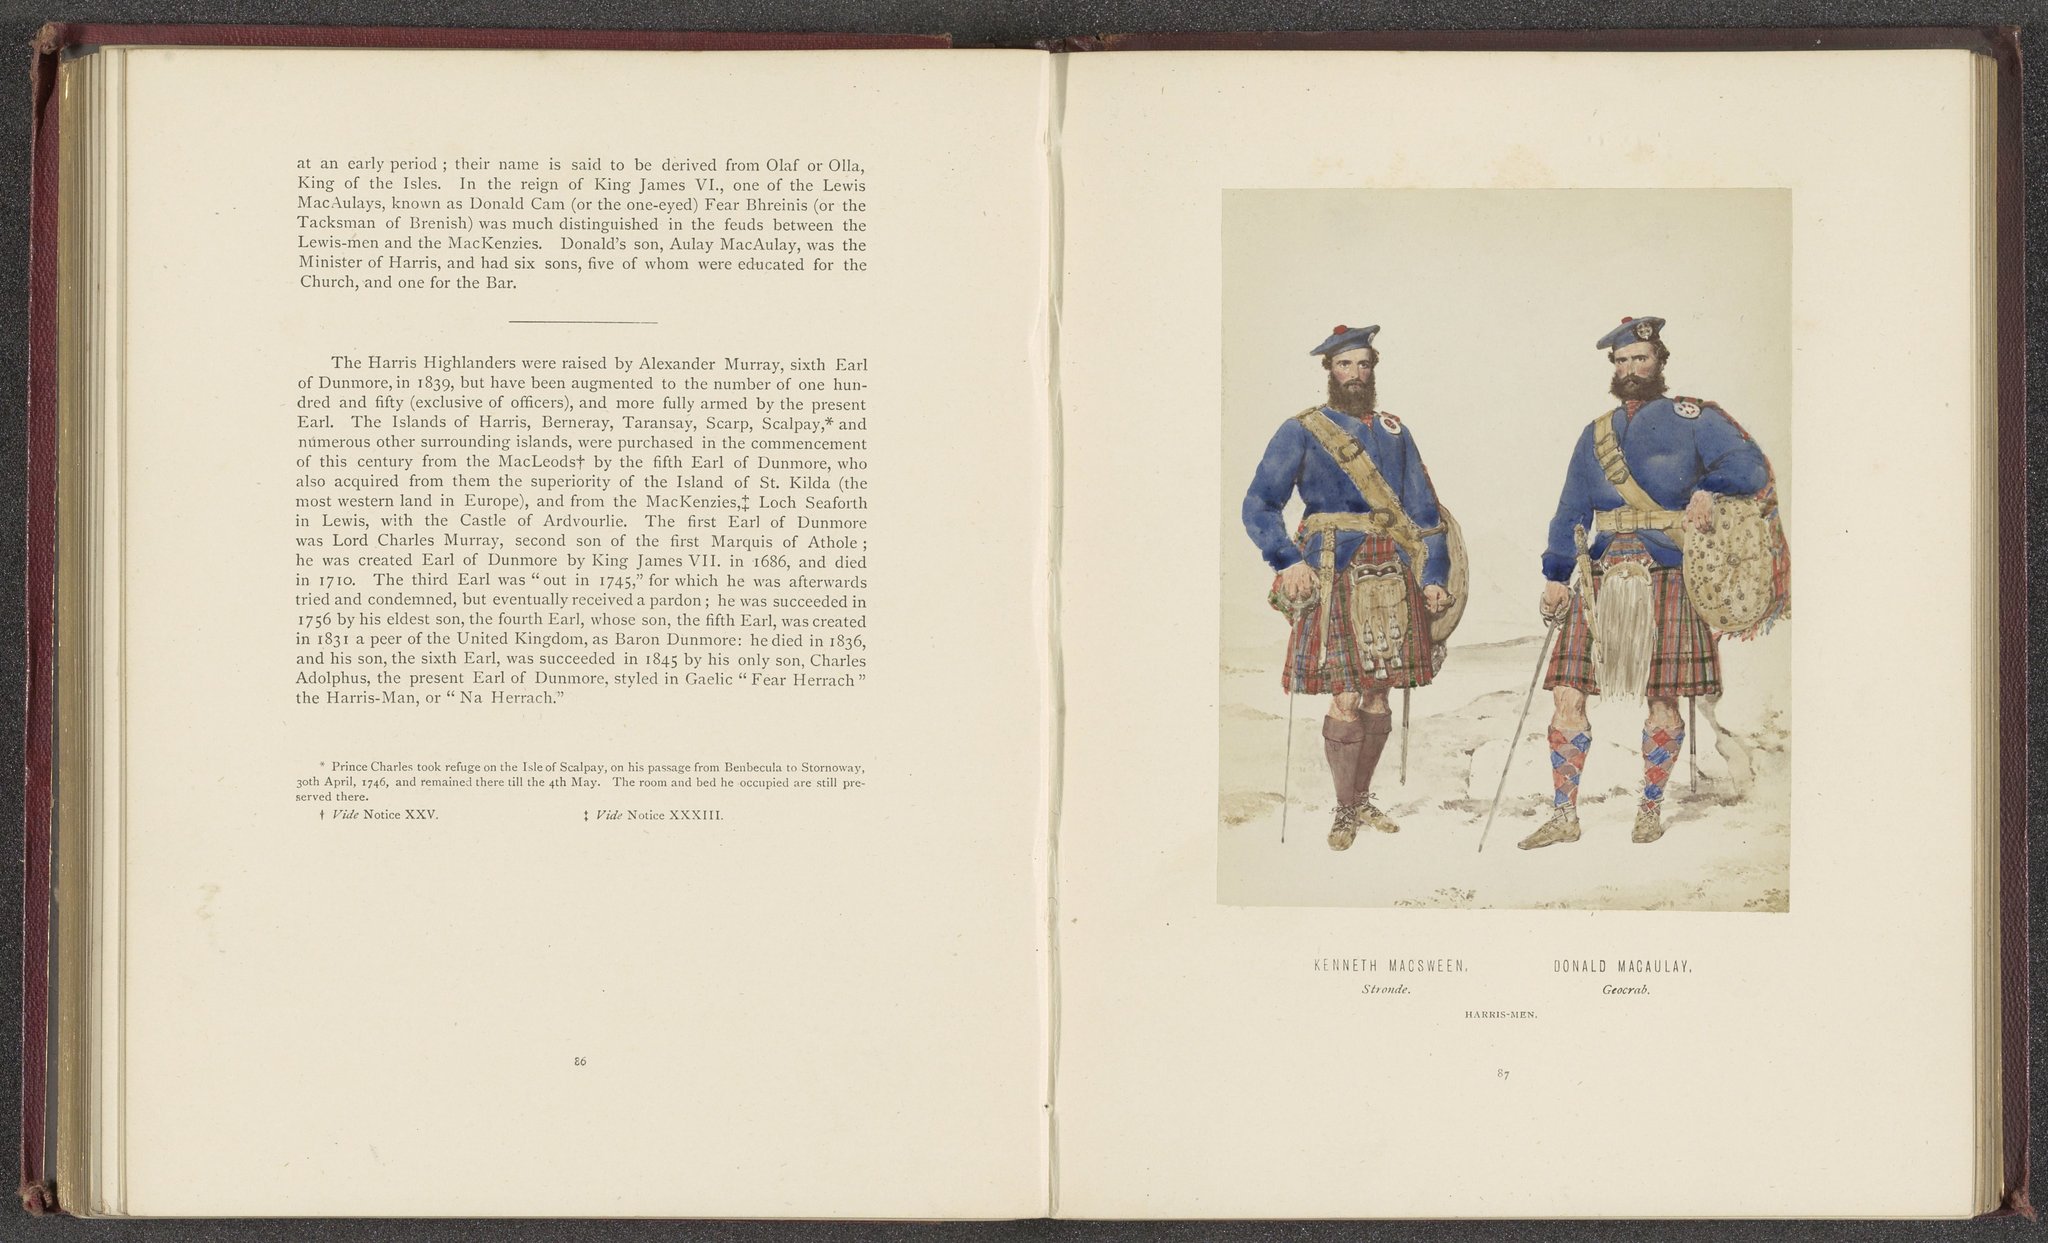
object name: photograph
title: Fotoreproductie van een tekening van portretten van Kenneth Macsween en Donald Macaulay uit Harris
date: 1860-1870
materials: photographic support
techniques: albumen print, hand coloring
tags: adult man, folk costume, regional costume